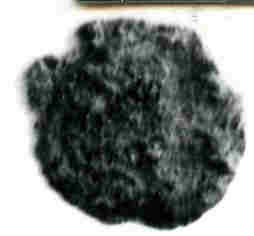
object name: coin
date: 401-1400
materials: copper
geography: iran